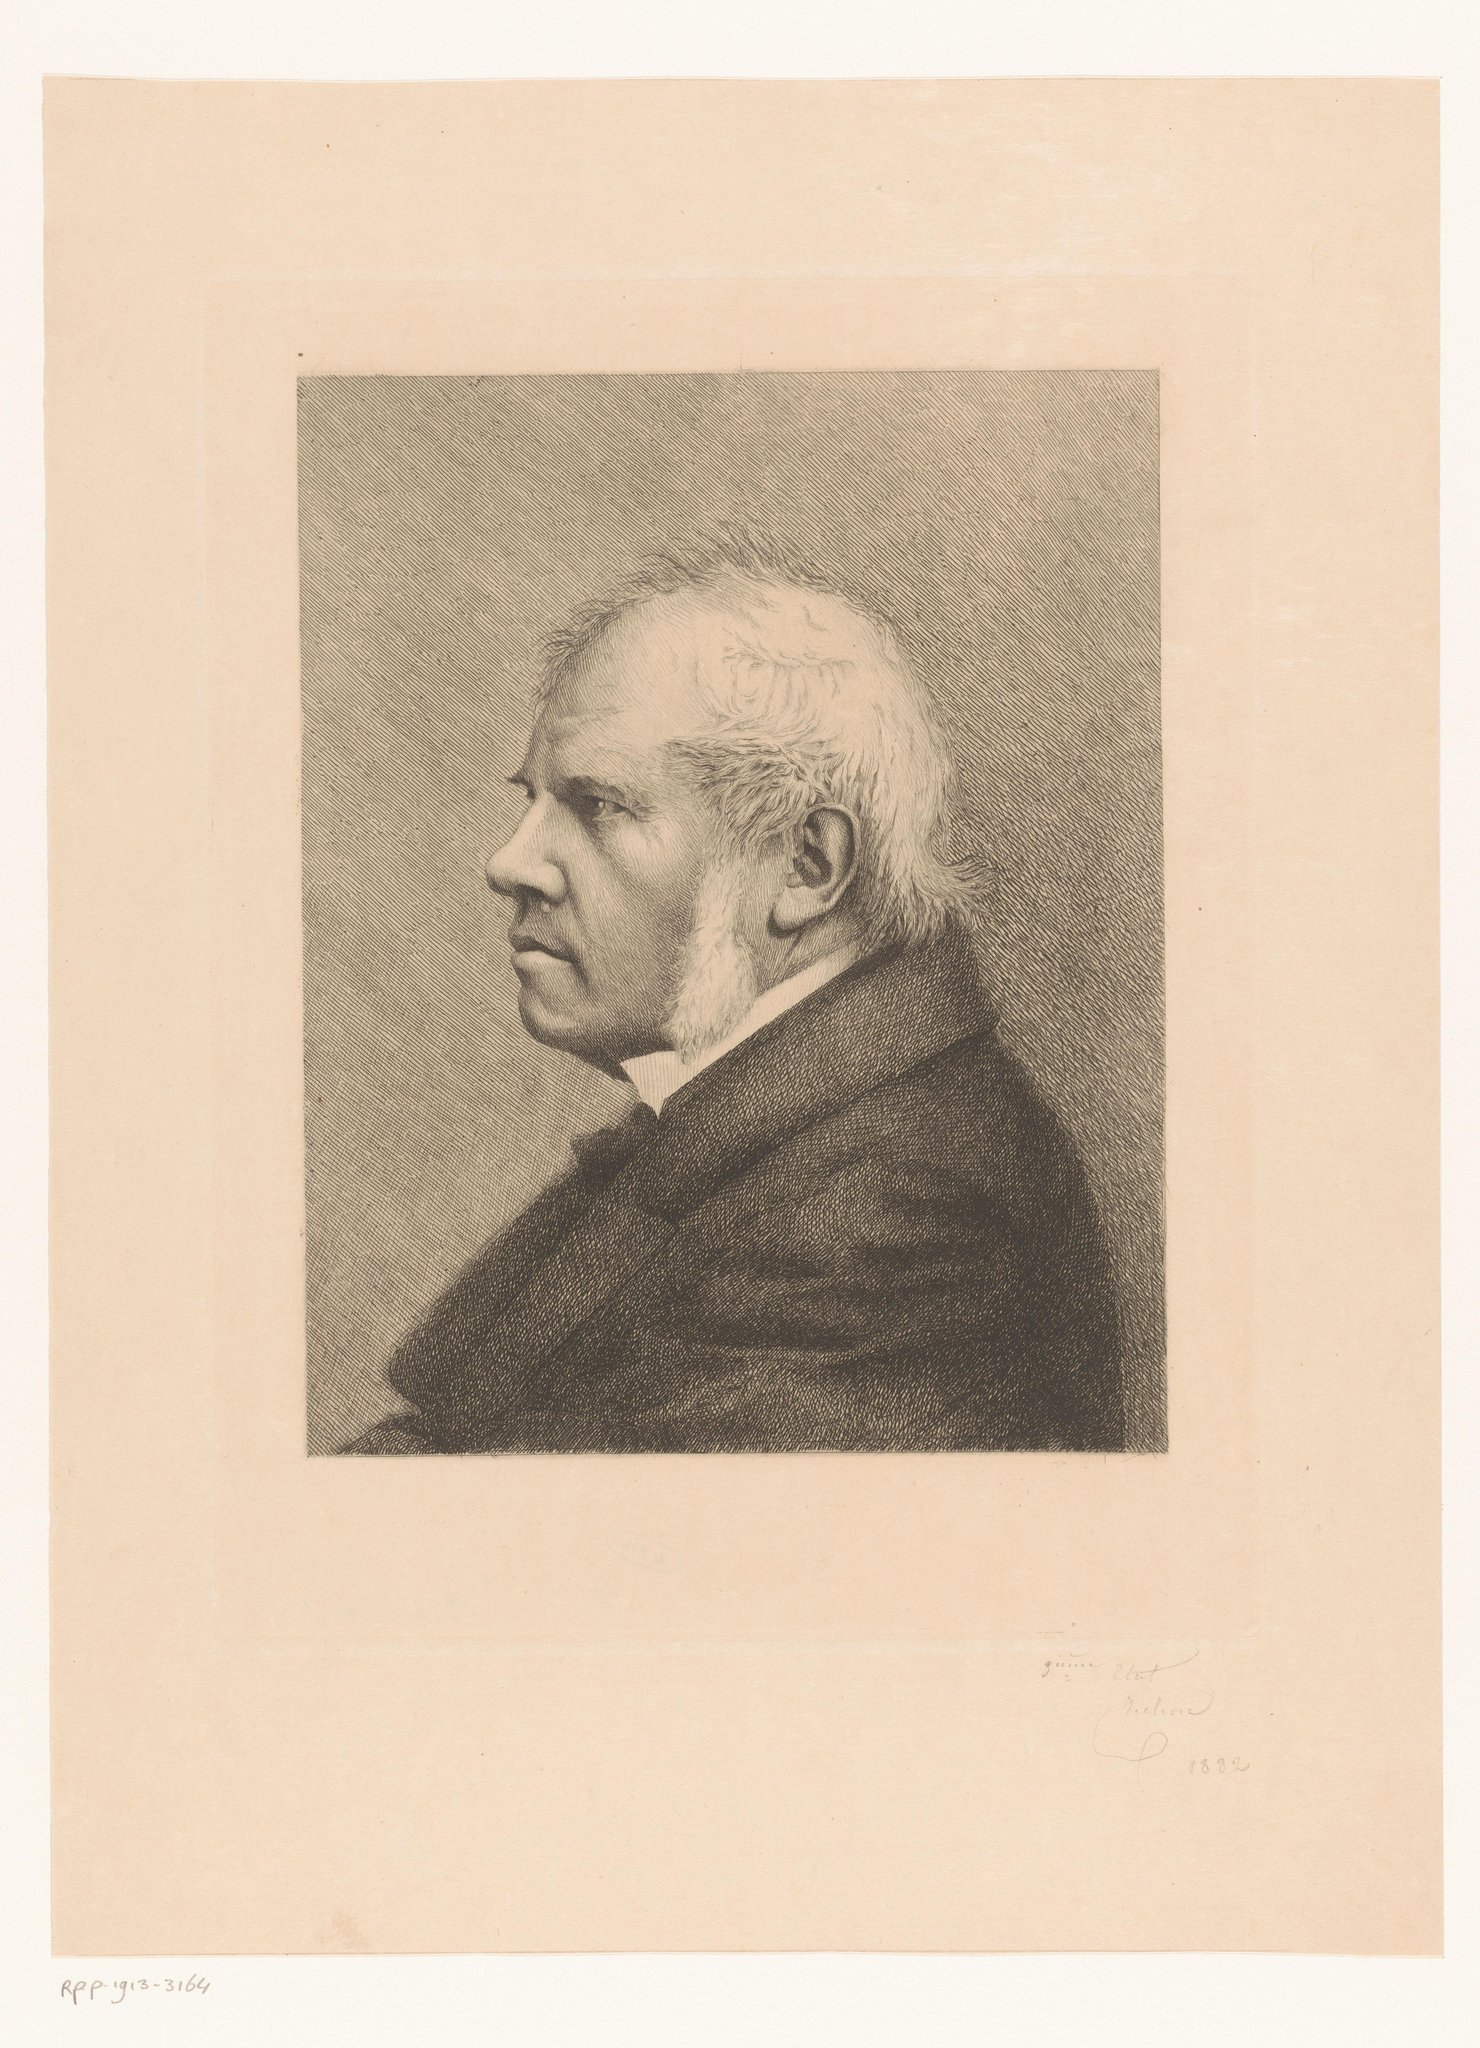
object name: print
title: Portret van een onbekende man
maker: charles tichon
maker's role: draughtsman, painter, print maker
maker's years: 1865-1924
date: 1882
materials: paper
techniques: etching, retroussage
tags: sideburns, adult man, historical persons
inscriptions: inscription: ‘3 ième Etat; 1882’, collector's mark: Lugt 2228